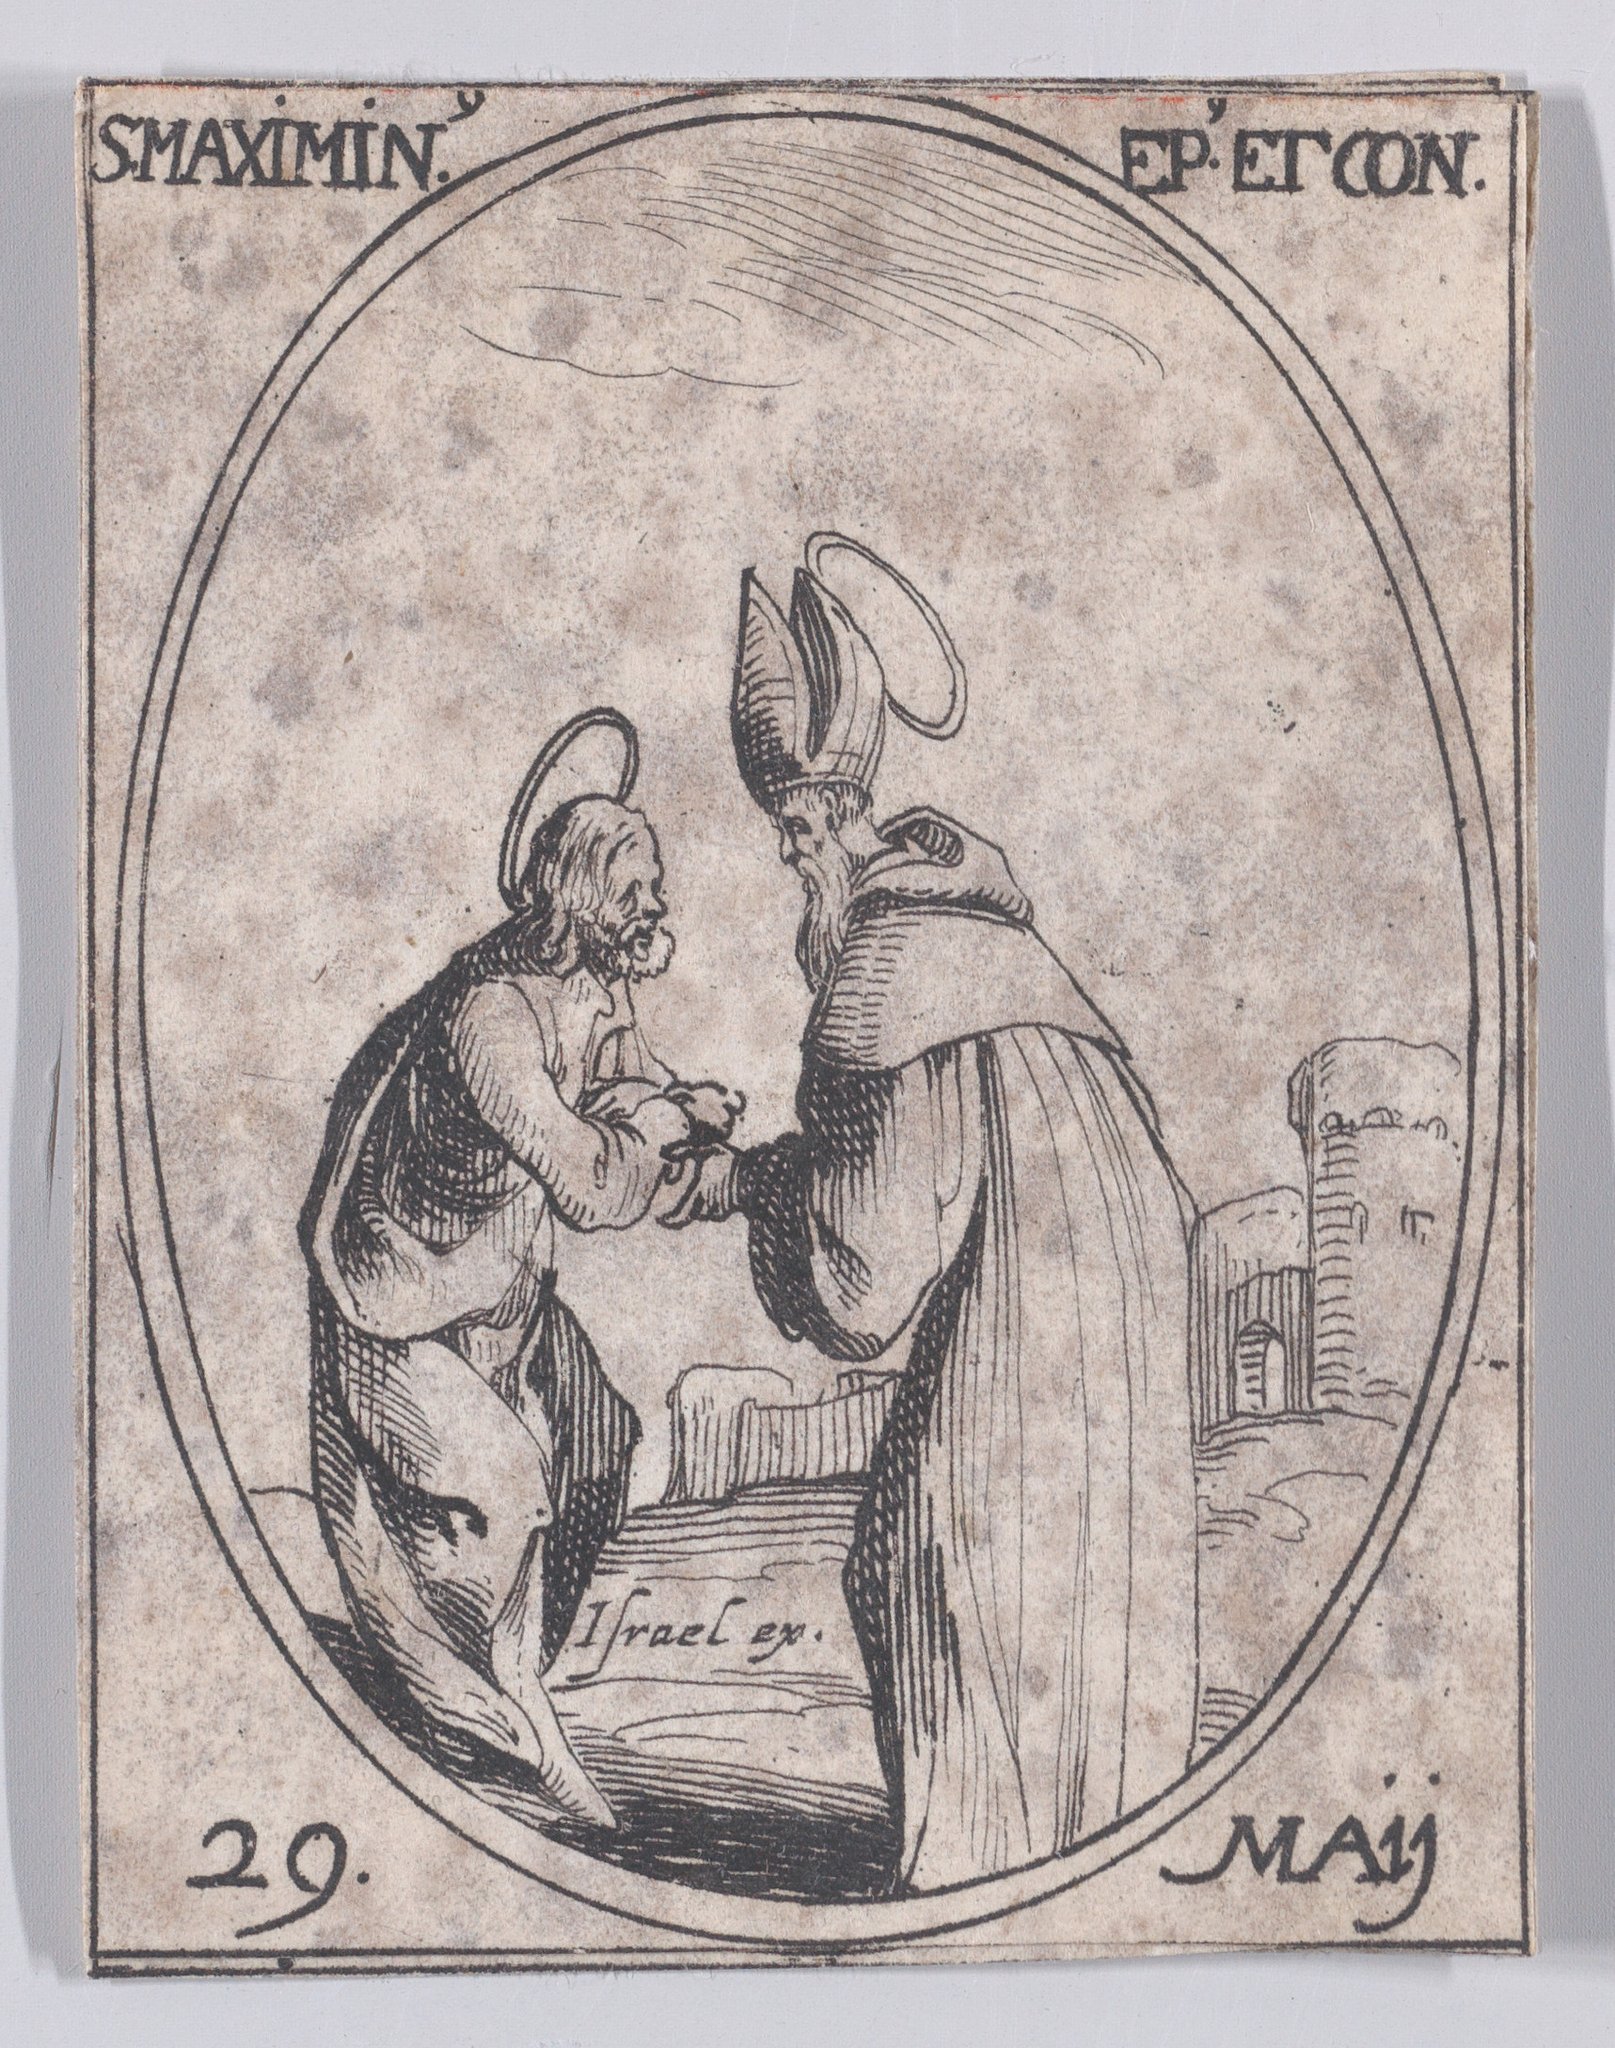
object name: print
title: S. Maximin, évêque et confesseur (St. Maximinus, Bishop and Confessor), May 29th, from "Les Images De Tous Les Saincts et Saintes de L'Année" (Images of All of the Saints and Religious Events of the Year)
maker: jacques callot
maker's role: artist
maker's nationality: french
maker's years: 1592-1635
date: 1636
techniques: etching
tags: men,saints